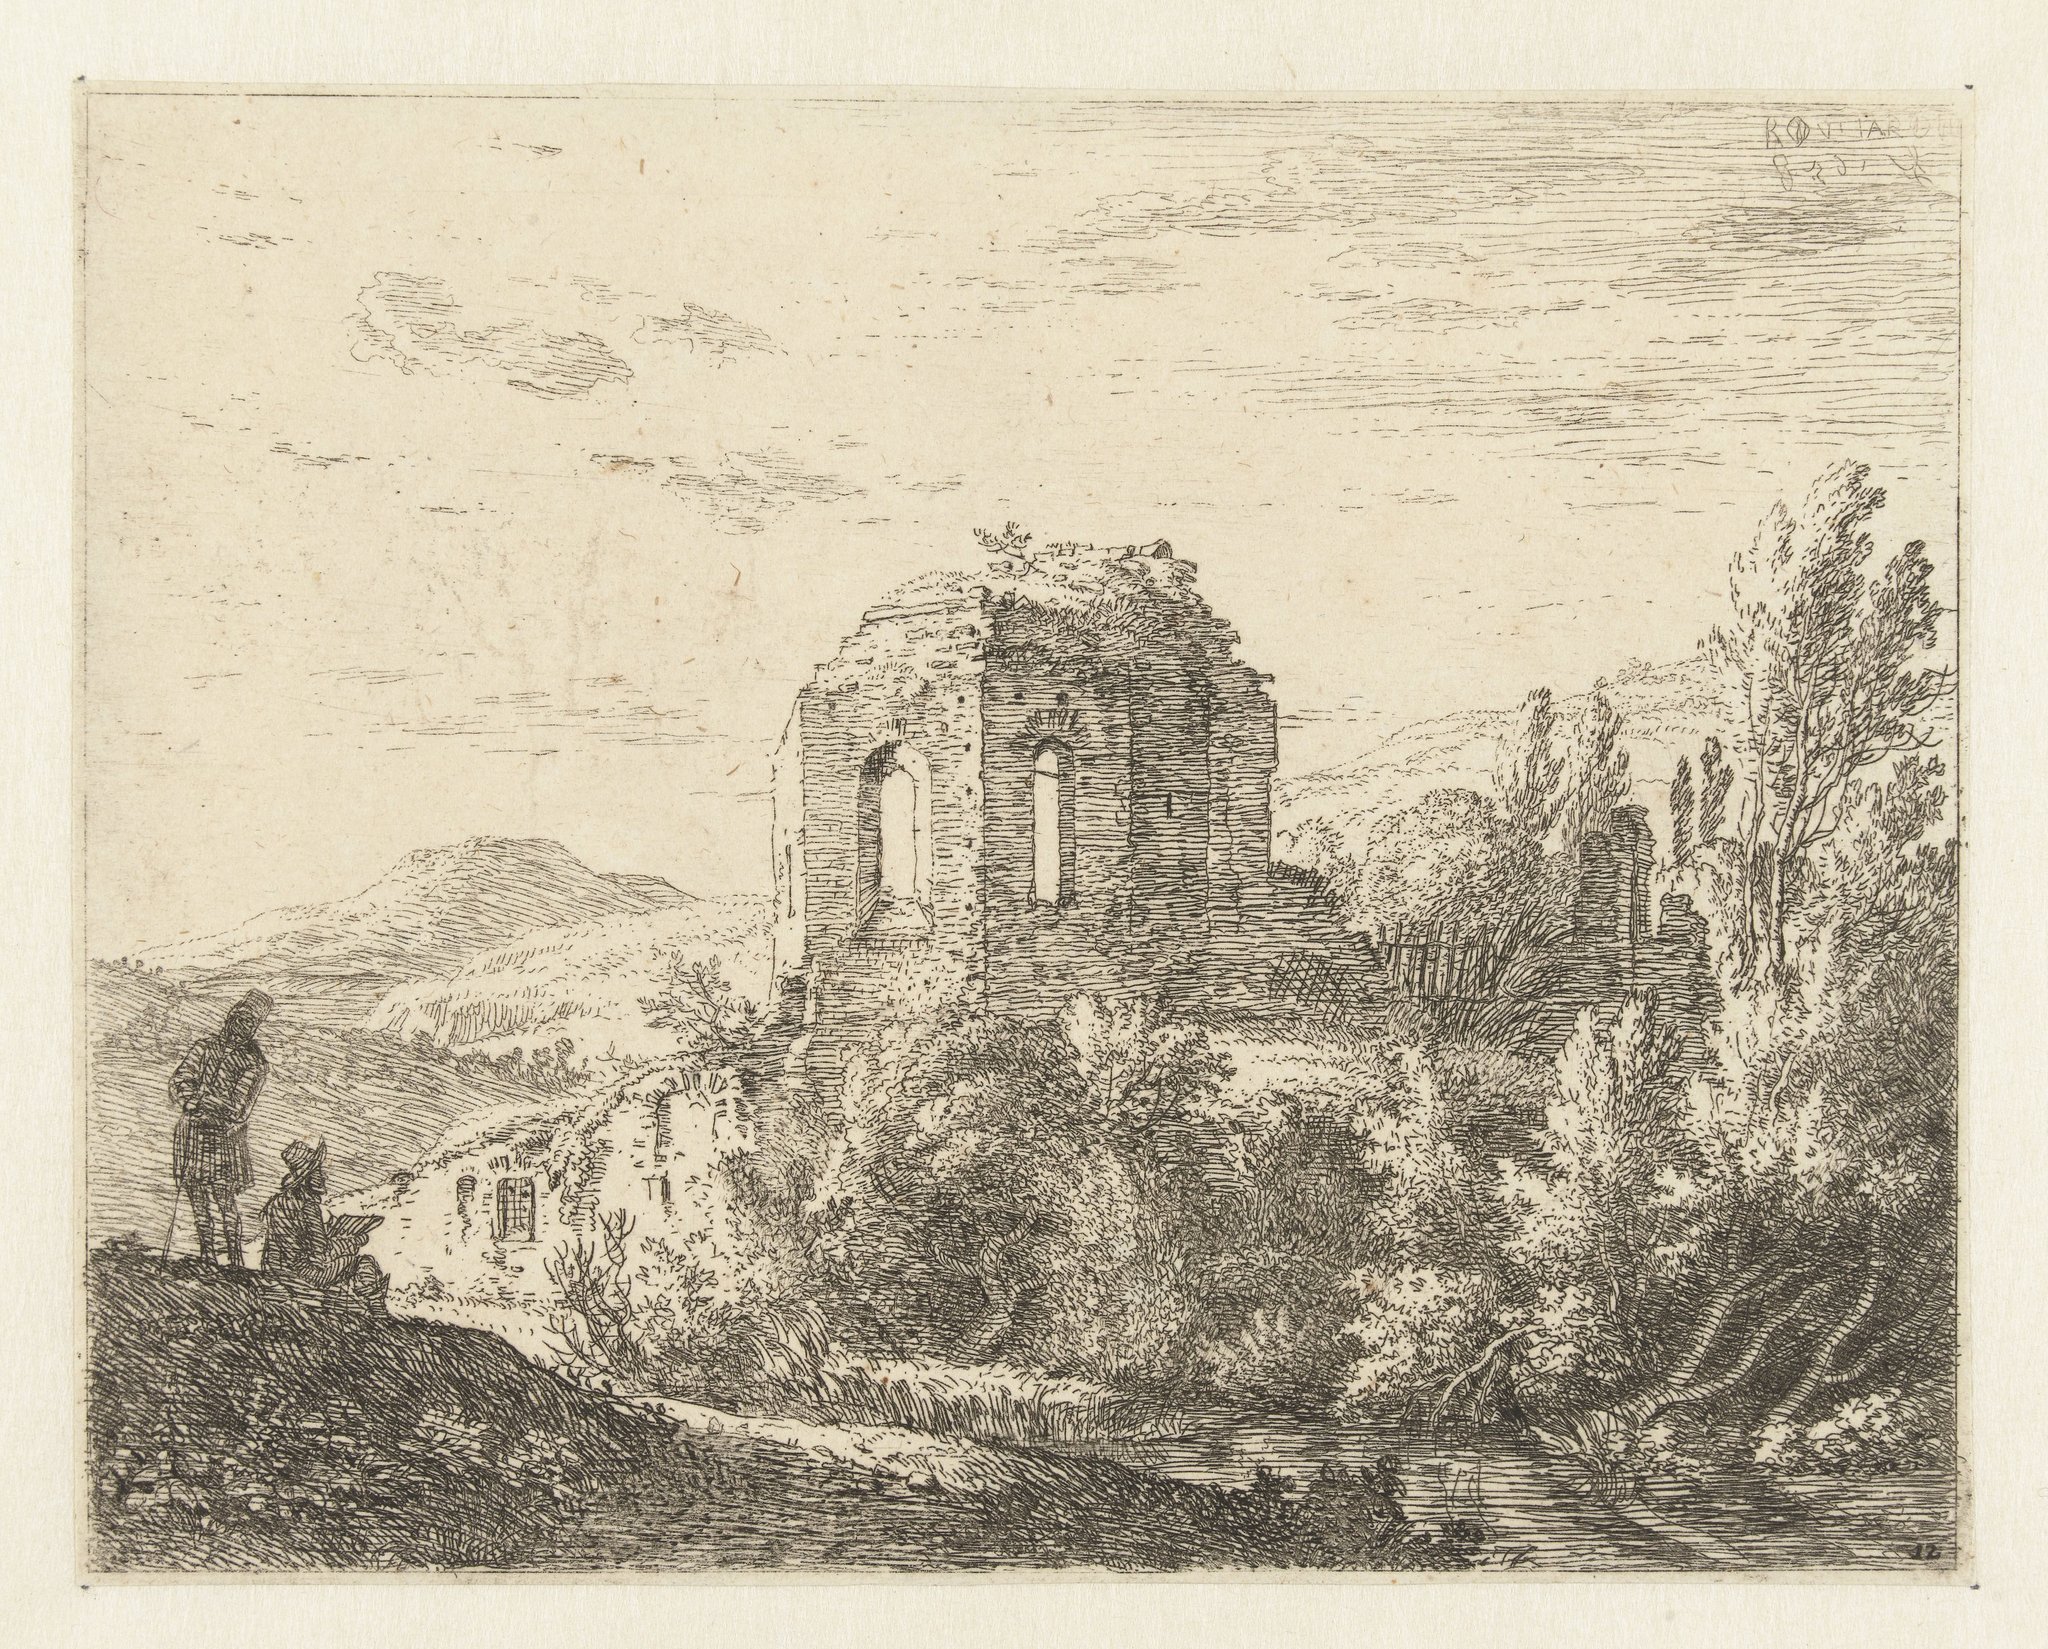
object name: print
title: Landschap met ruïne van een tempel en twee tekenaars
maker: karel du jardin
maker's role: draughtsman, painter, print maker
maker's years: 1626-1678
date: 1658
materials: paper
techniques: etching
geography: the hague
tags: low hill country, landscape with ruins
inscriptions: collector's mark: Lugt 2228a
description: Hollstein nrs. 9-12 lijken deel uit te maken van een serie.